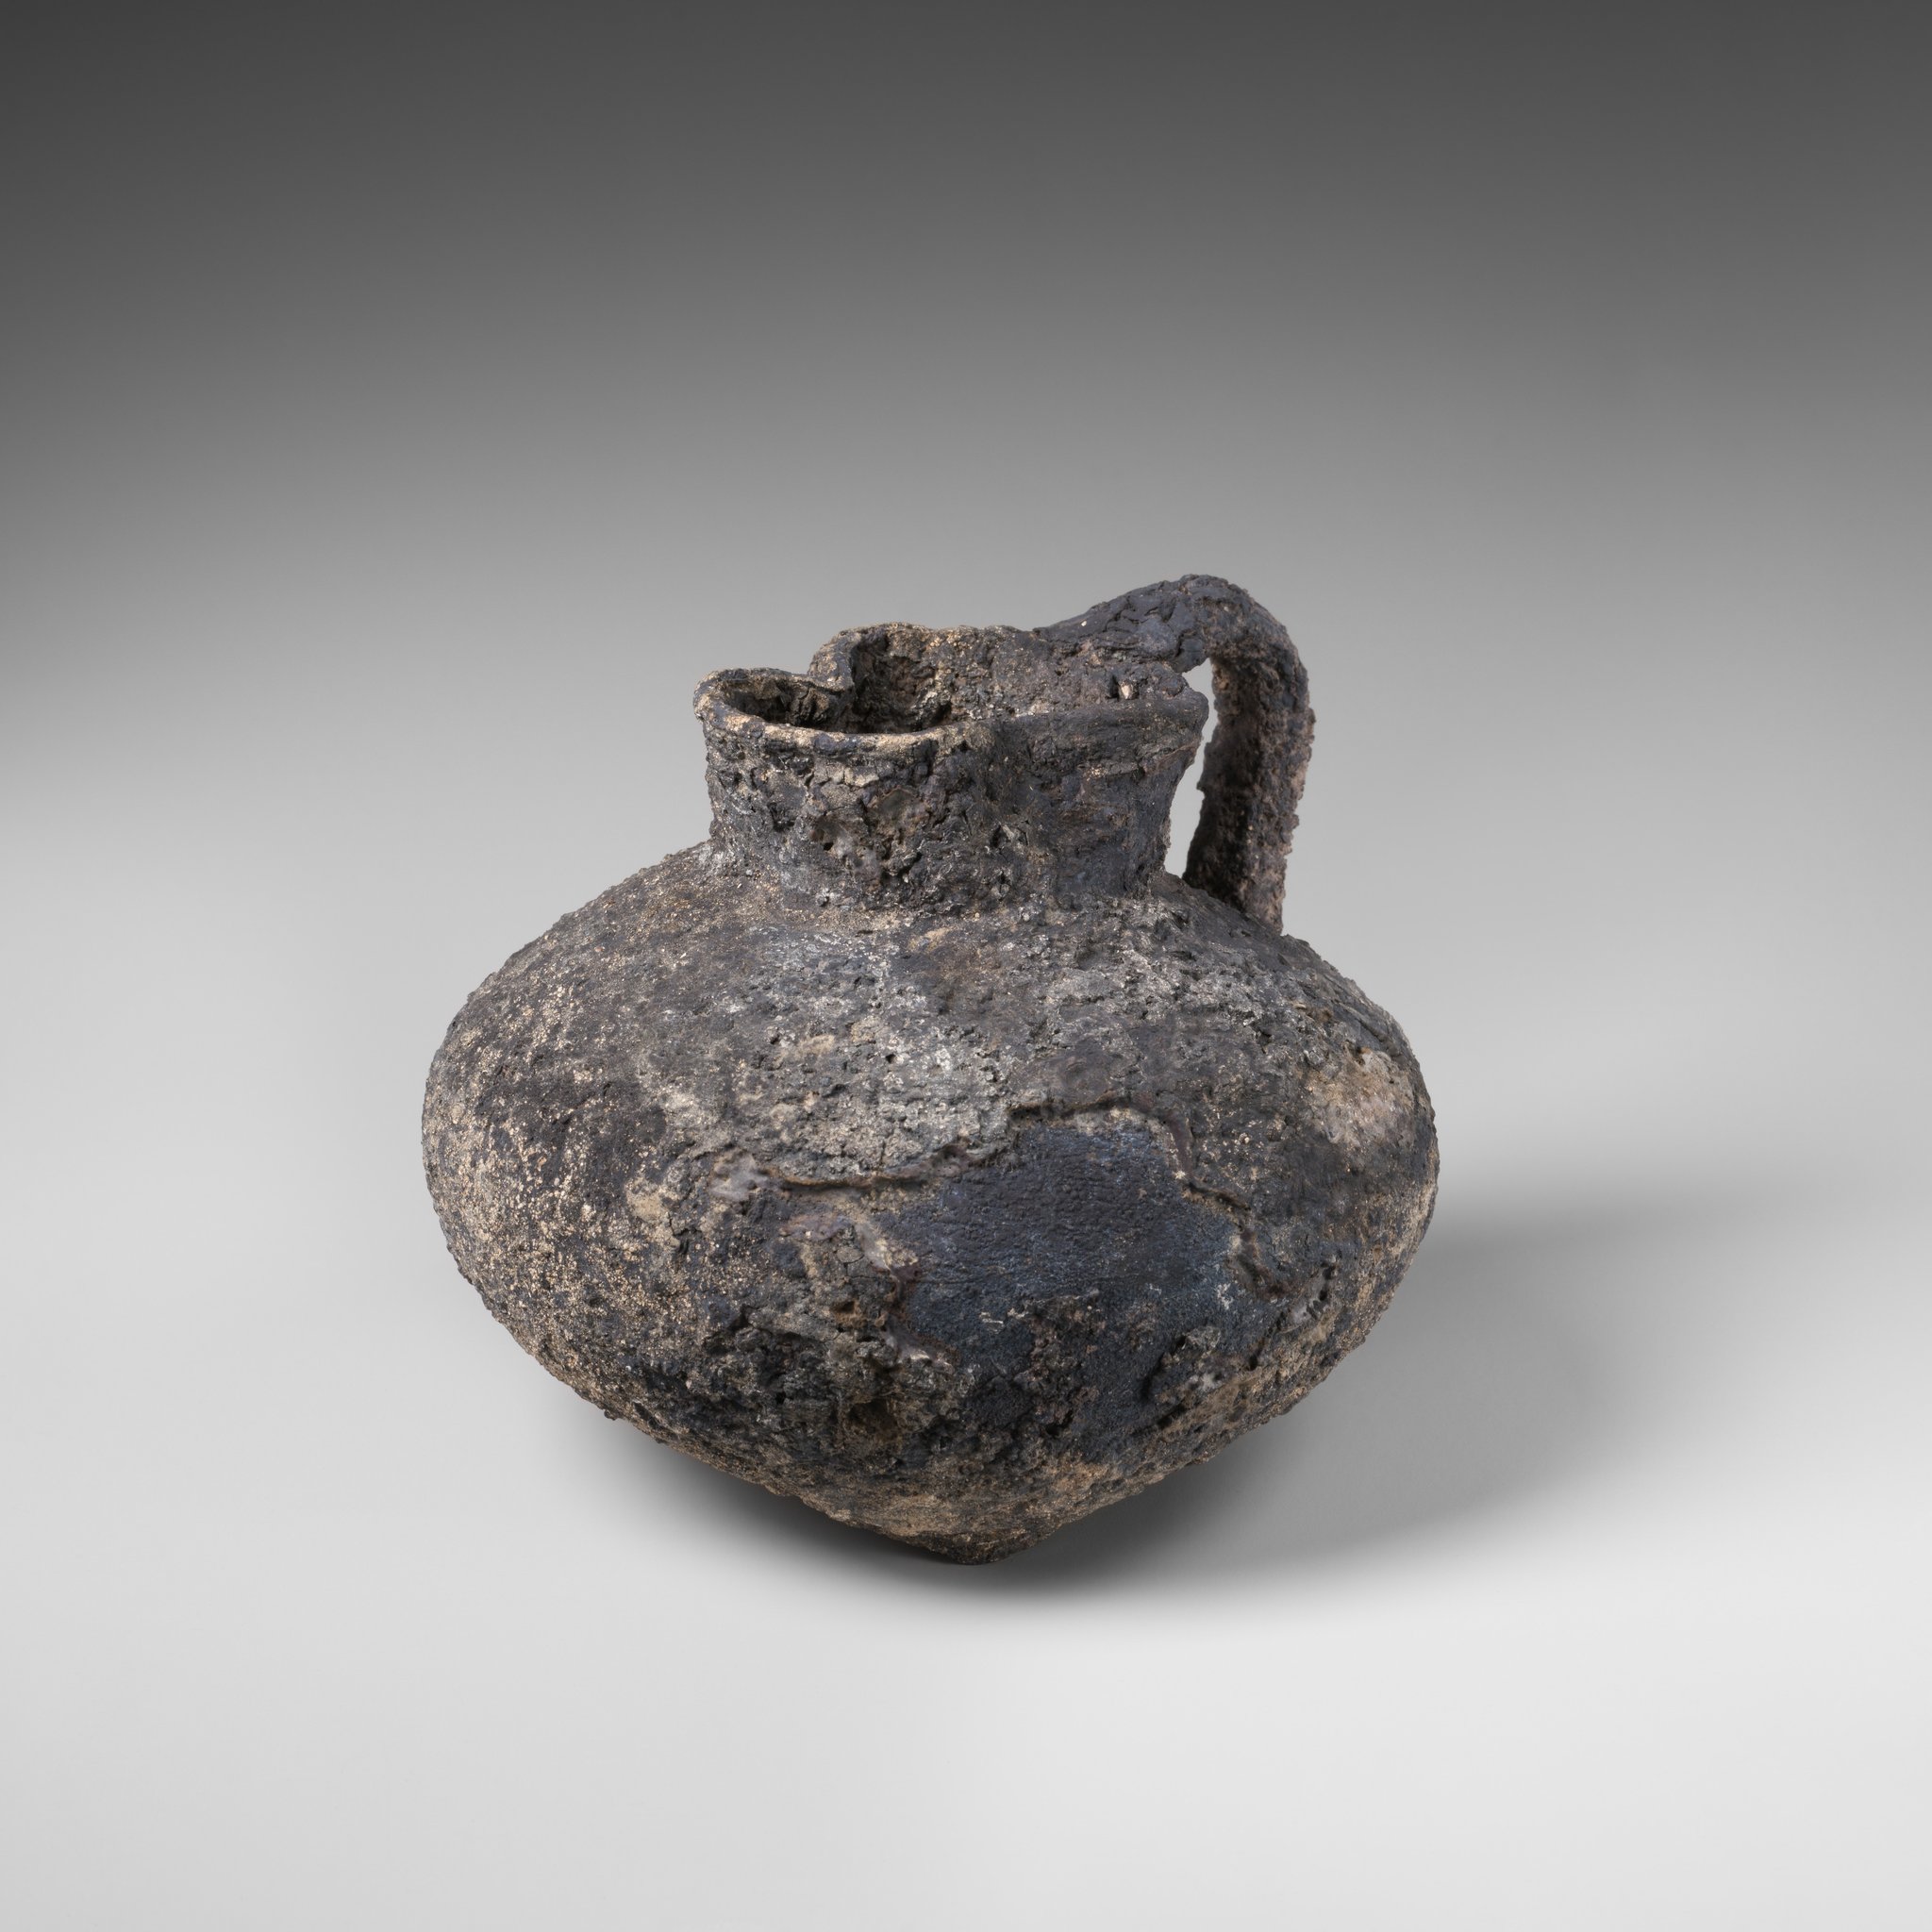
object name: juglet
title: Silver jug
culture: cypriot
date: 700-601 BCE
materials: silver